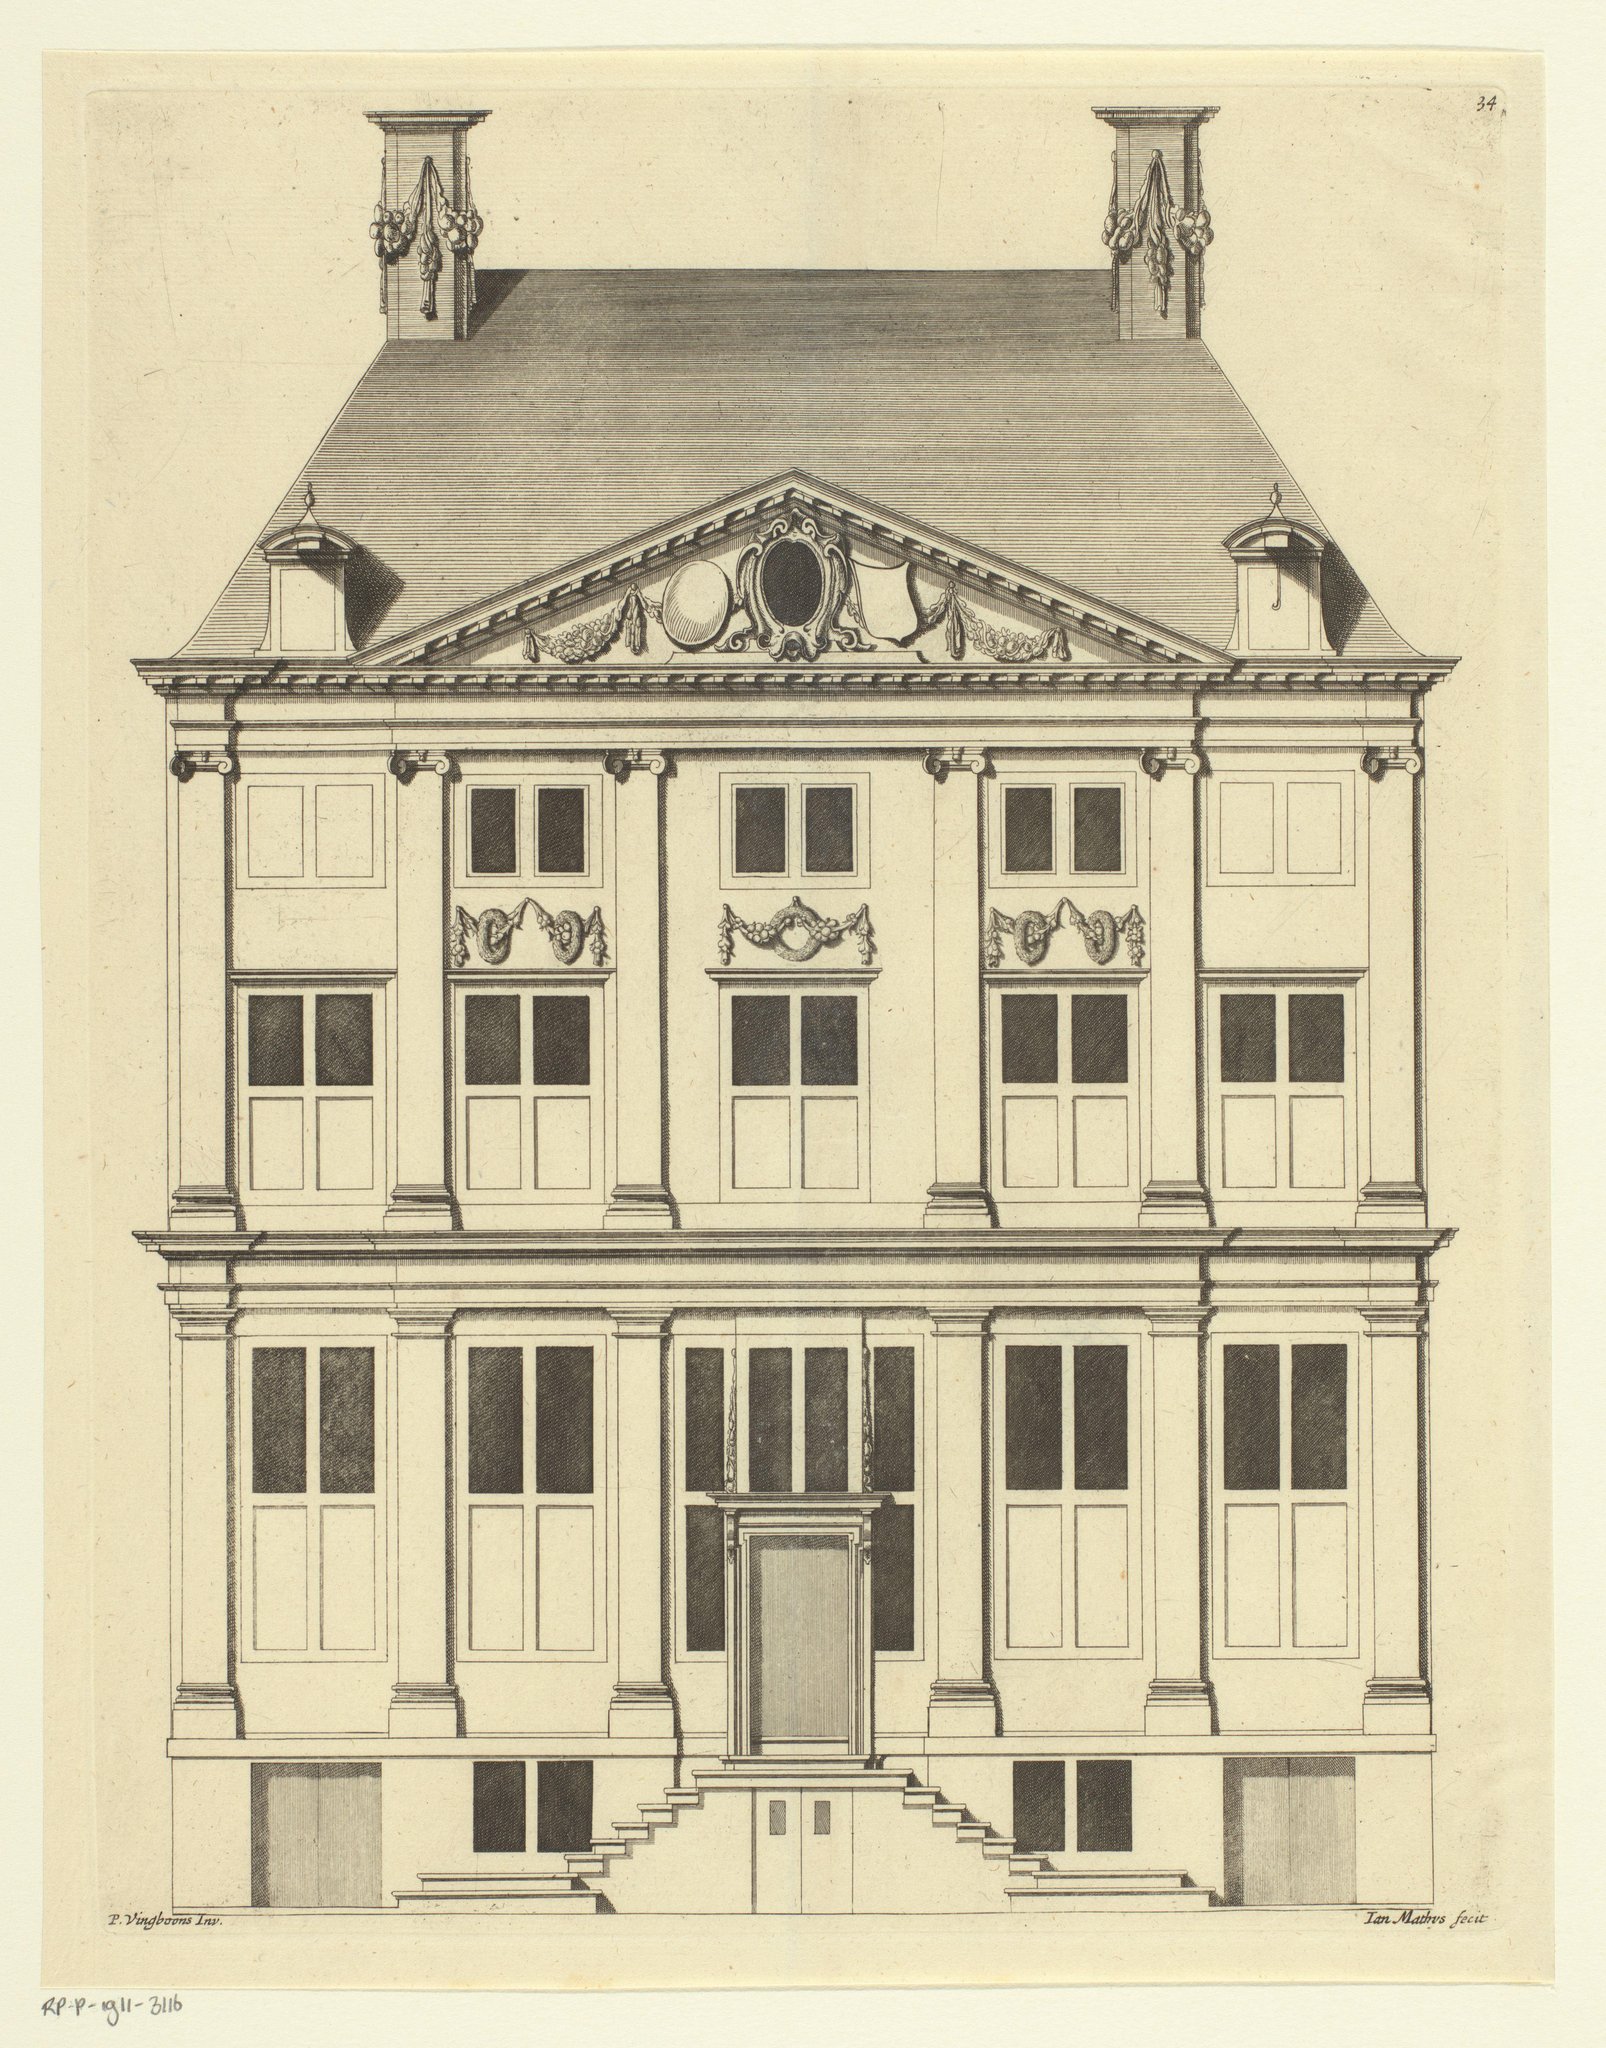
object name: print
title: Gevel van een woonhuis in Amsterdam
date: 1674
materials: paper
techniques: engraving, etching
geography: amsterdam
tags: exterior ~ architectural design or model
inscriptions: collector's mark: Lugt 2228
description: Prent uit: Vingboons, Philips. Tweede deel van de afbeeldsels der voornaemste gebovwen, uyt alle die Philips Vingboons geordineert heeft. Amsterdam: Philips Vingboons en Joan Blaeu, 1674.